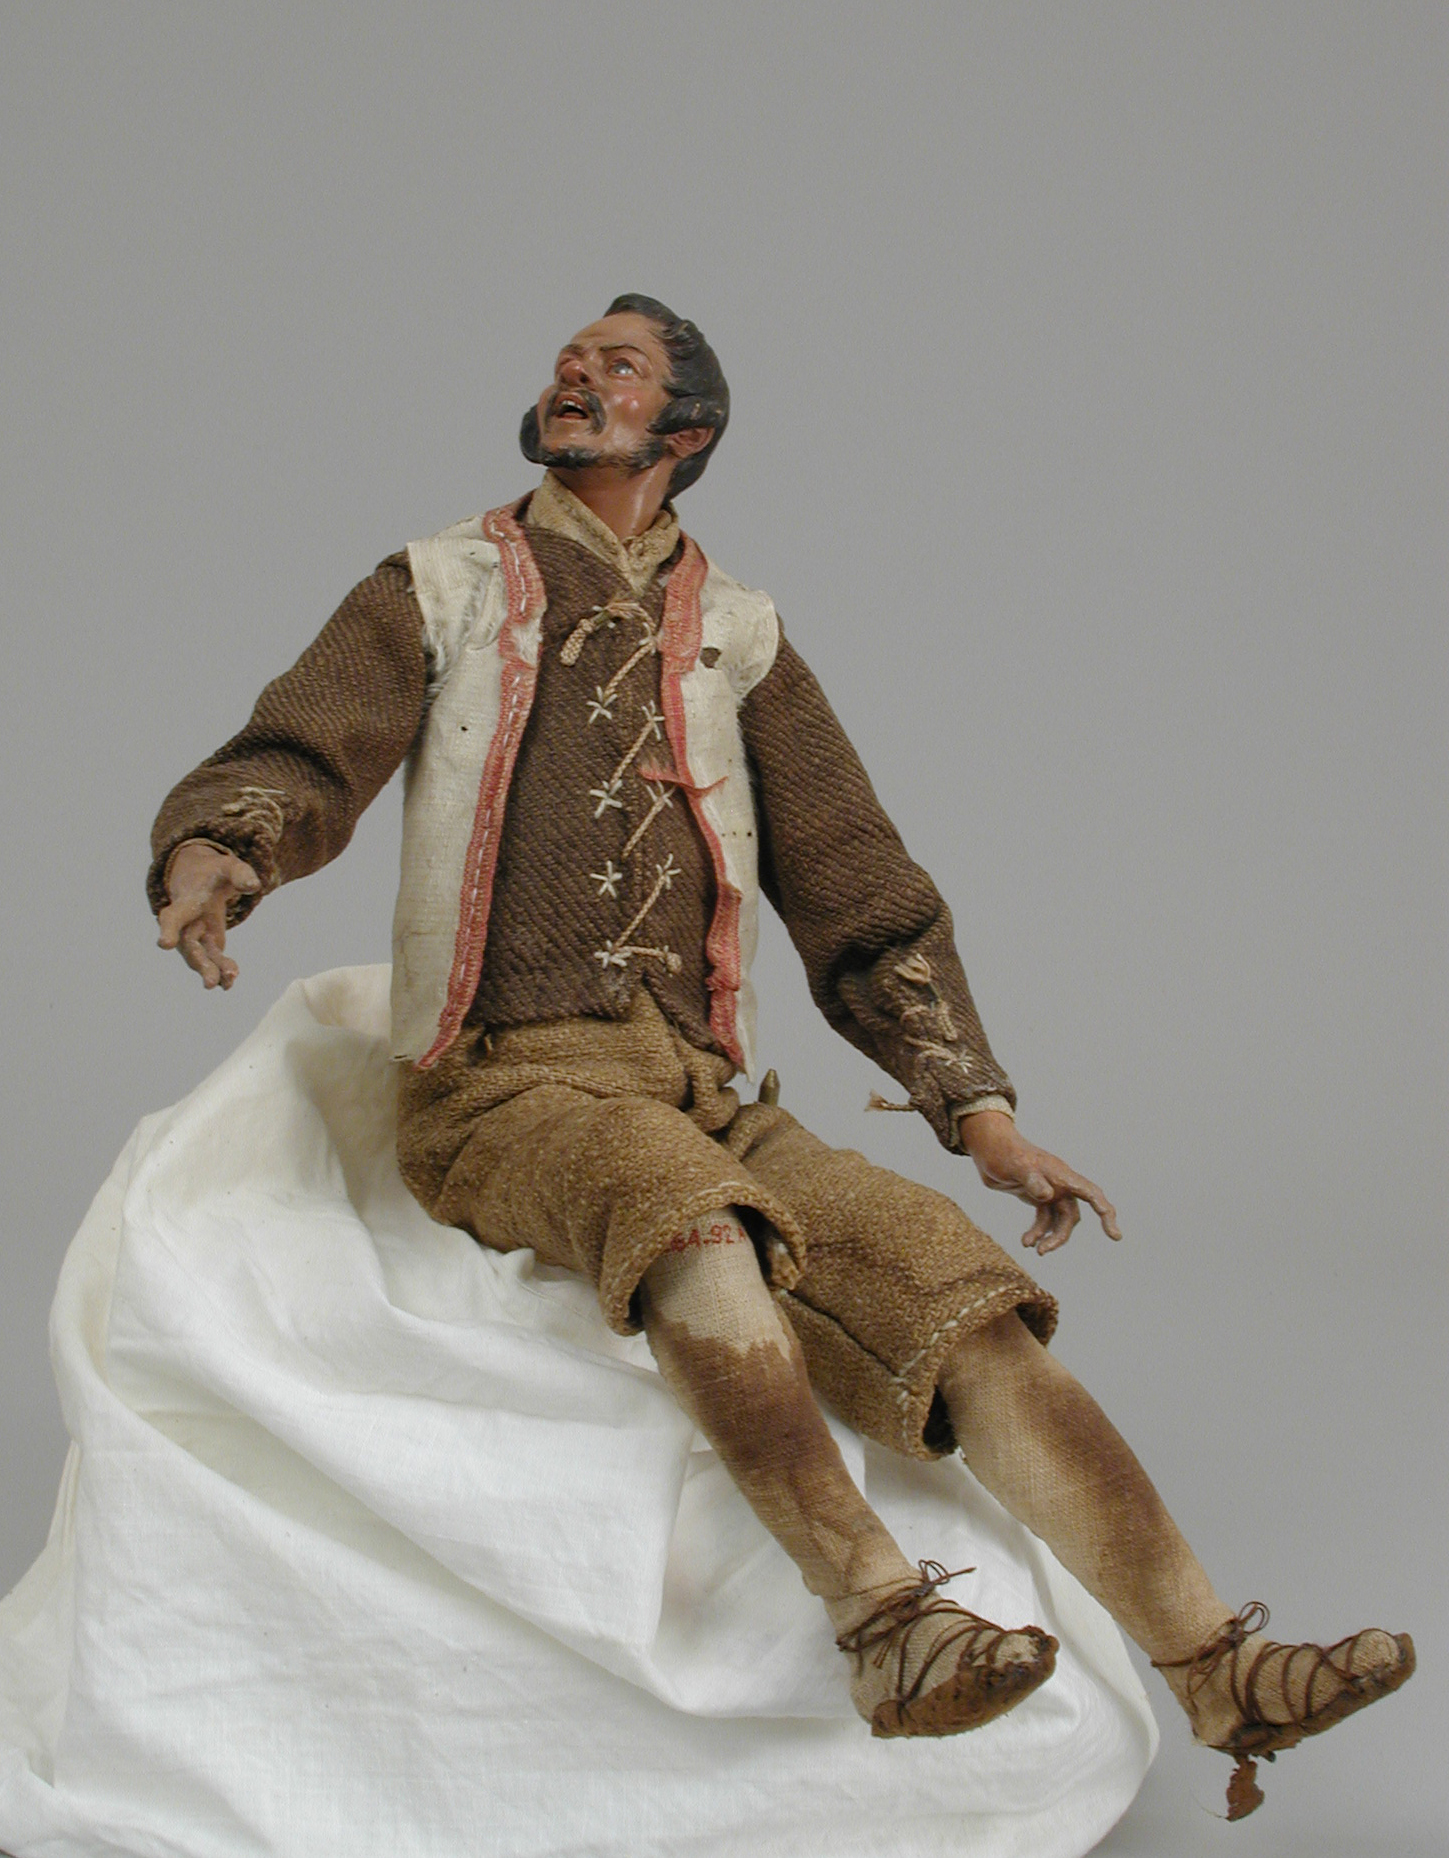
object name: crèche figure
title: Shepherd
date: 1751-1800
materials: cotton, leather, terracotta, fiber, metal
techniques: polychrome